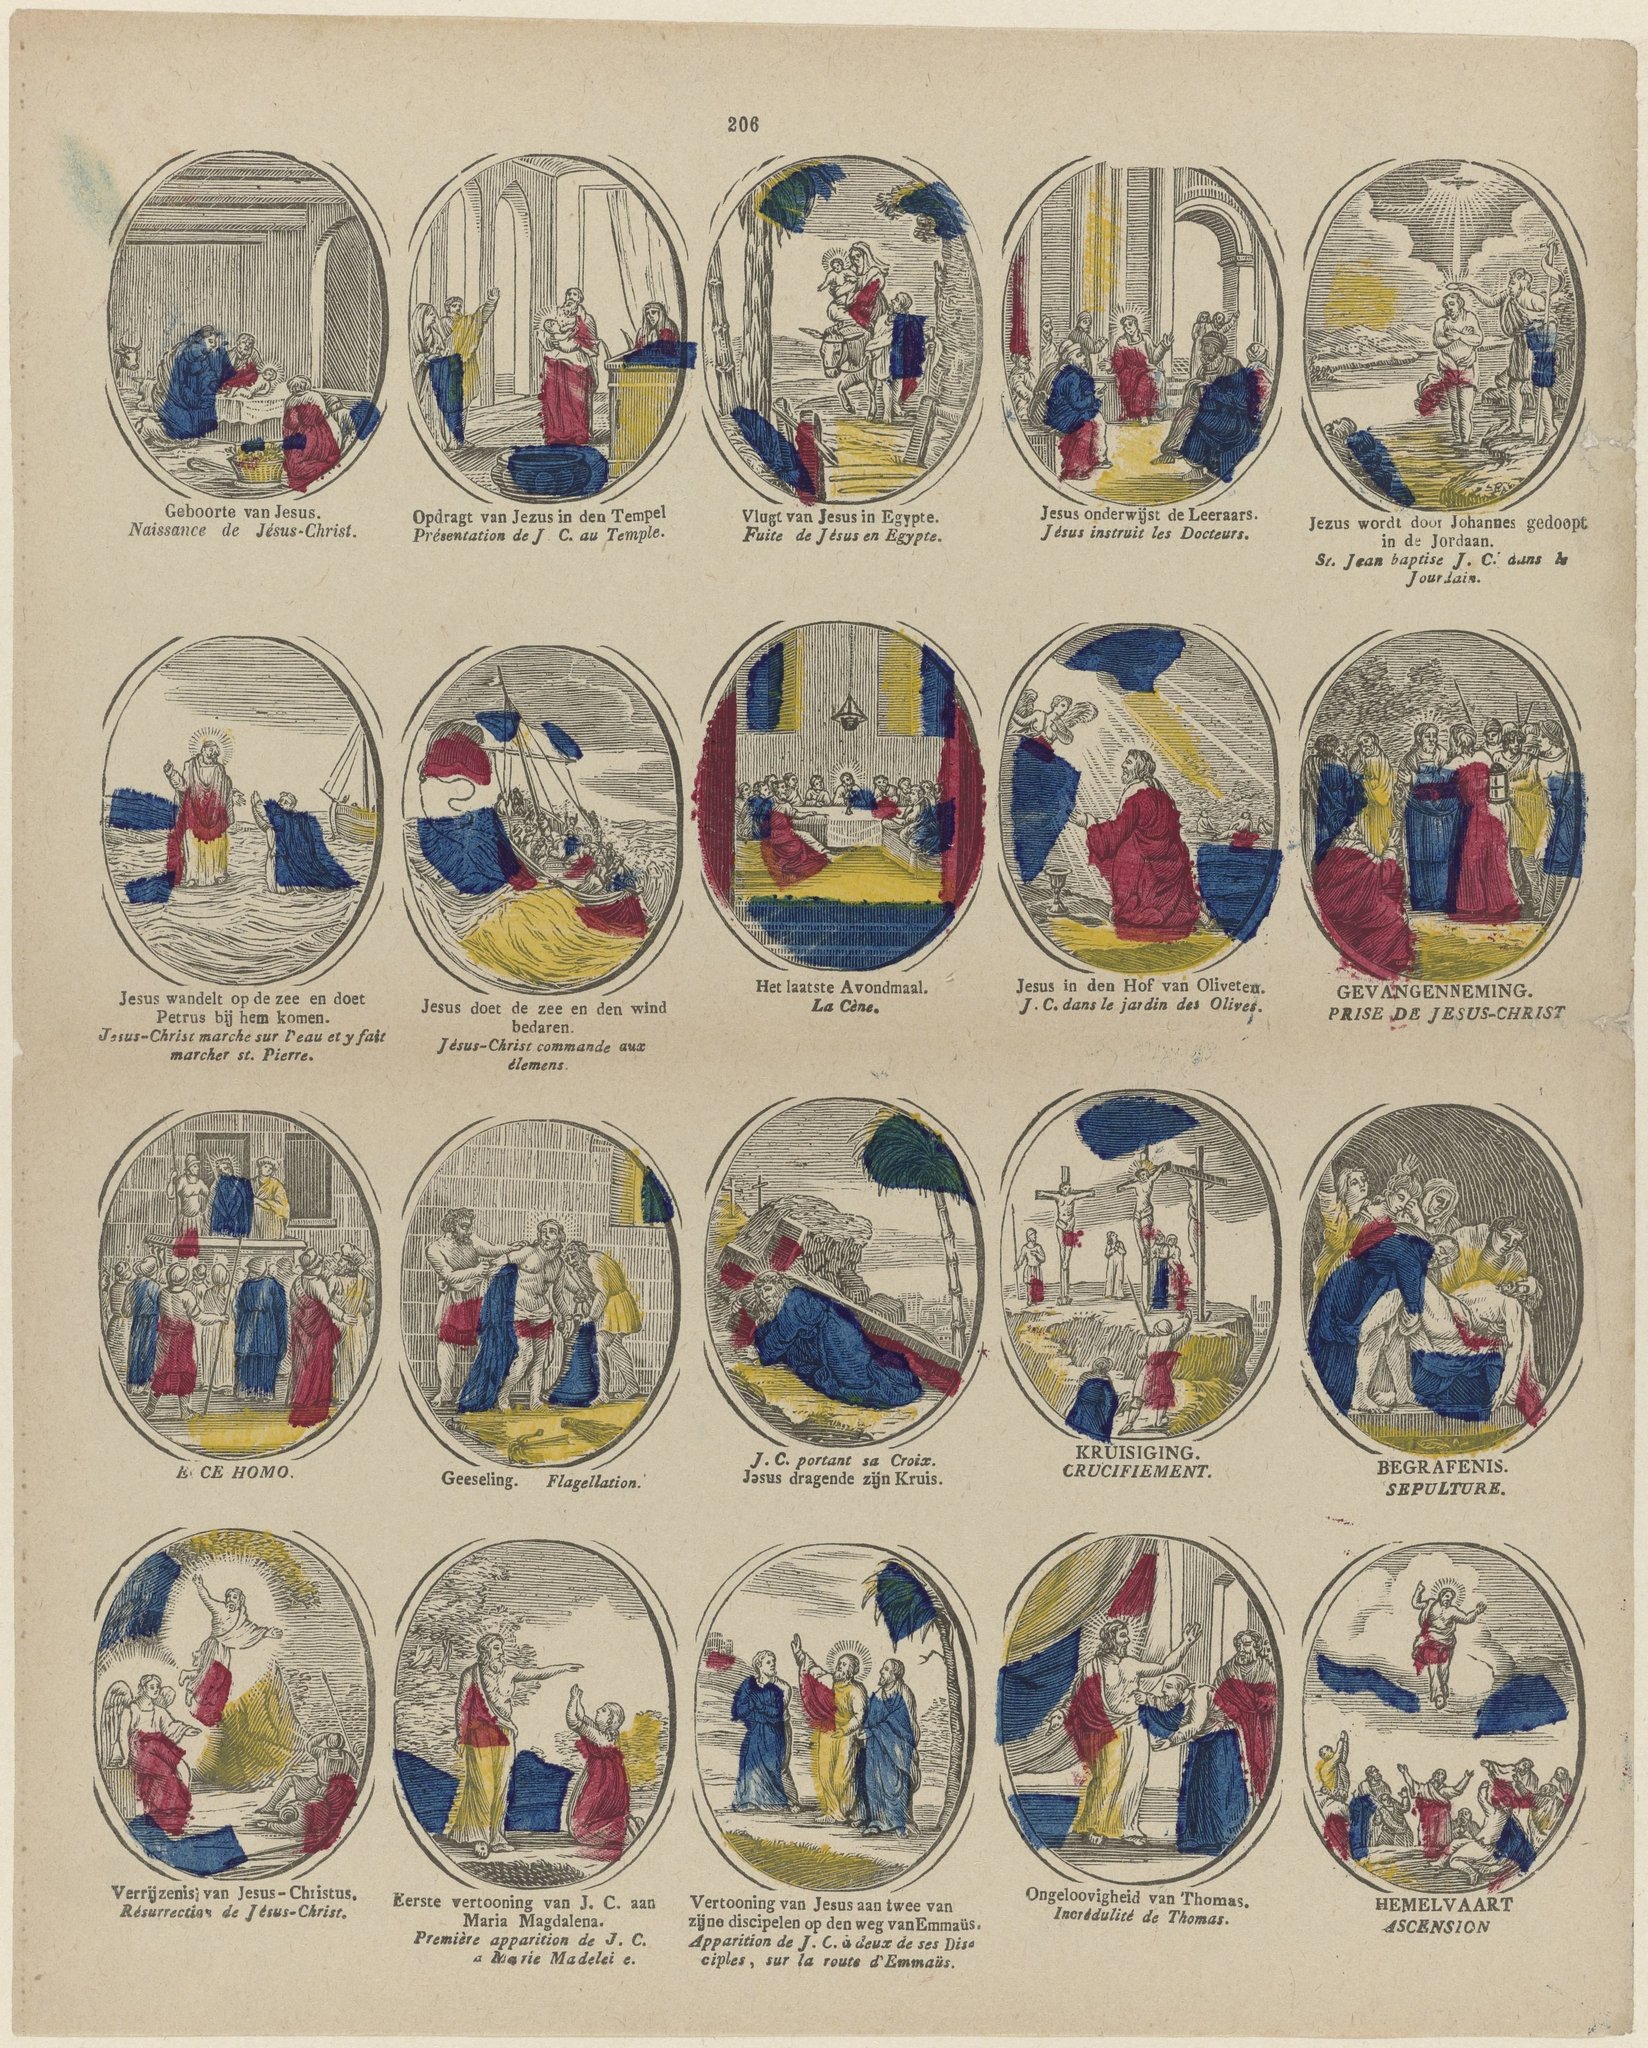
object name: popular print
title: Het leven van Christus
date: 1800-1833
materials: paper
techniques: colour, letterpress printing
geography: turnhout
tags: the flight into egypt: mary, joseph, the child (and sometimes others) on their way; mary usually riding on an ass, series of scenes from the life of christ, passion of christ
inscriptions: collector's mark: Lugt 2760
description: Blad met 20 ovale medaillions met voorstellingen uit het leven van Christus, waaronder de geboorte van Christus, de vlucht naar Egypte, de Kruisdraging en de hemelvaart van Christus. Onder elke voorstelling een onderschrift in het Nederlands en in het Frans. Genummerd midden boven: 206.